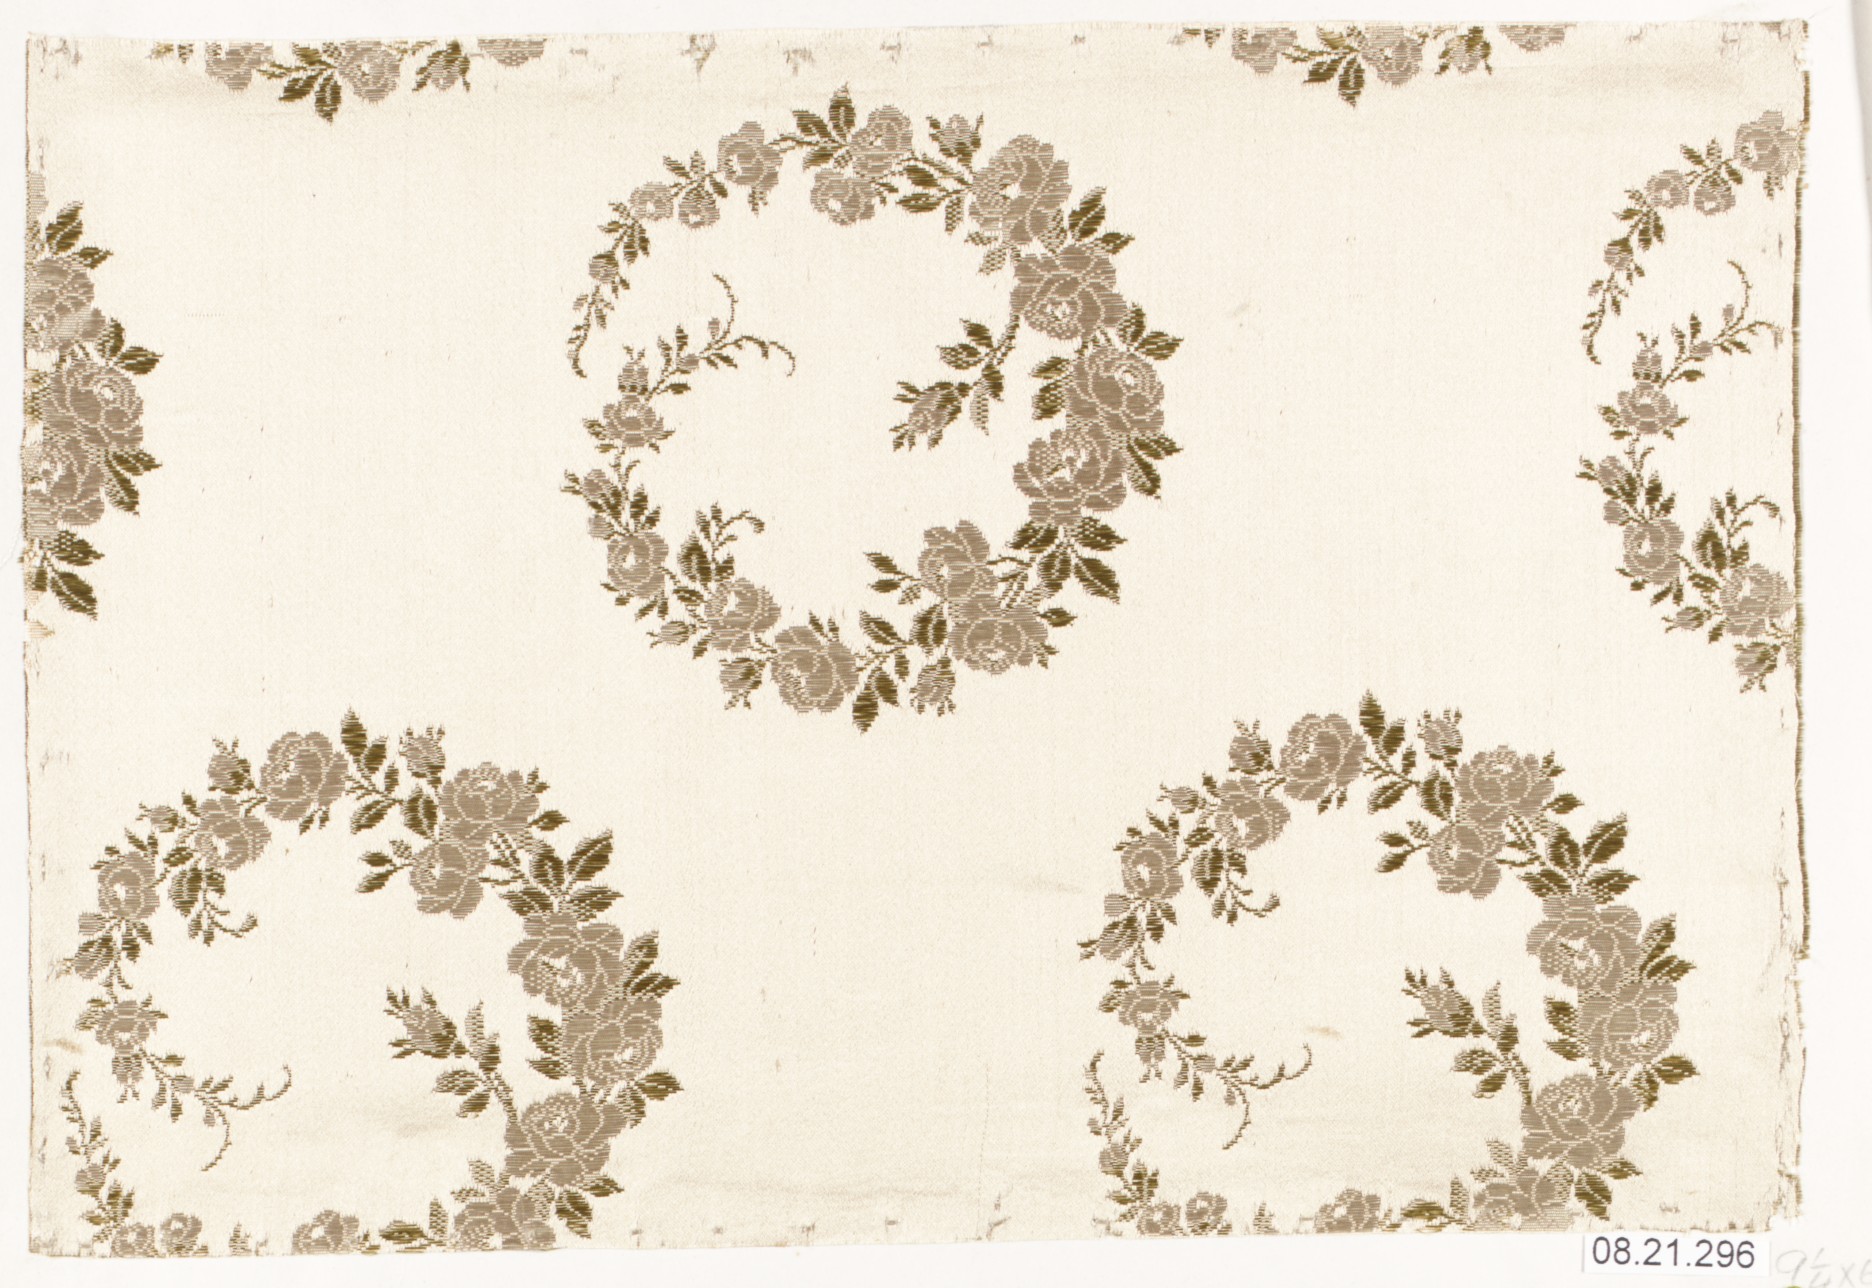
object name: textile sample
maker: Anonymous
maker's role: designer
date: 1900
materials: silk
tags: flowers